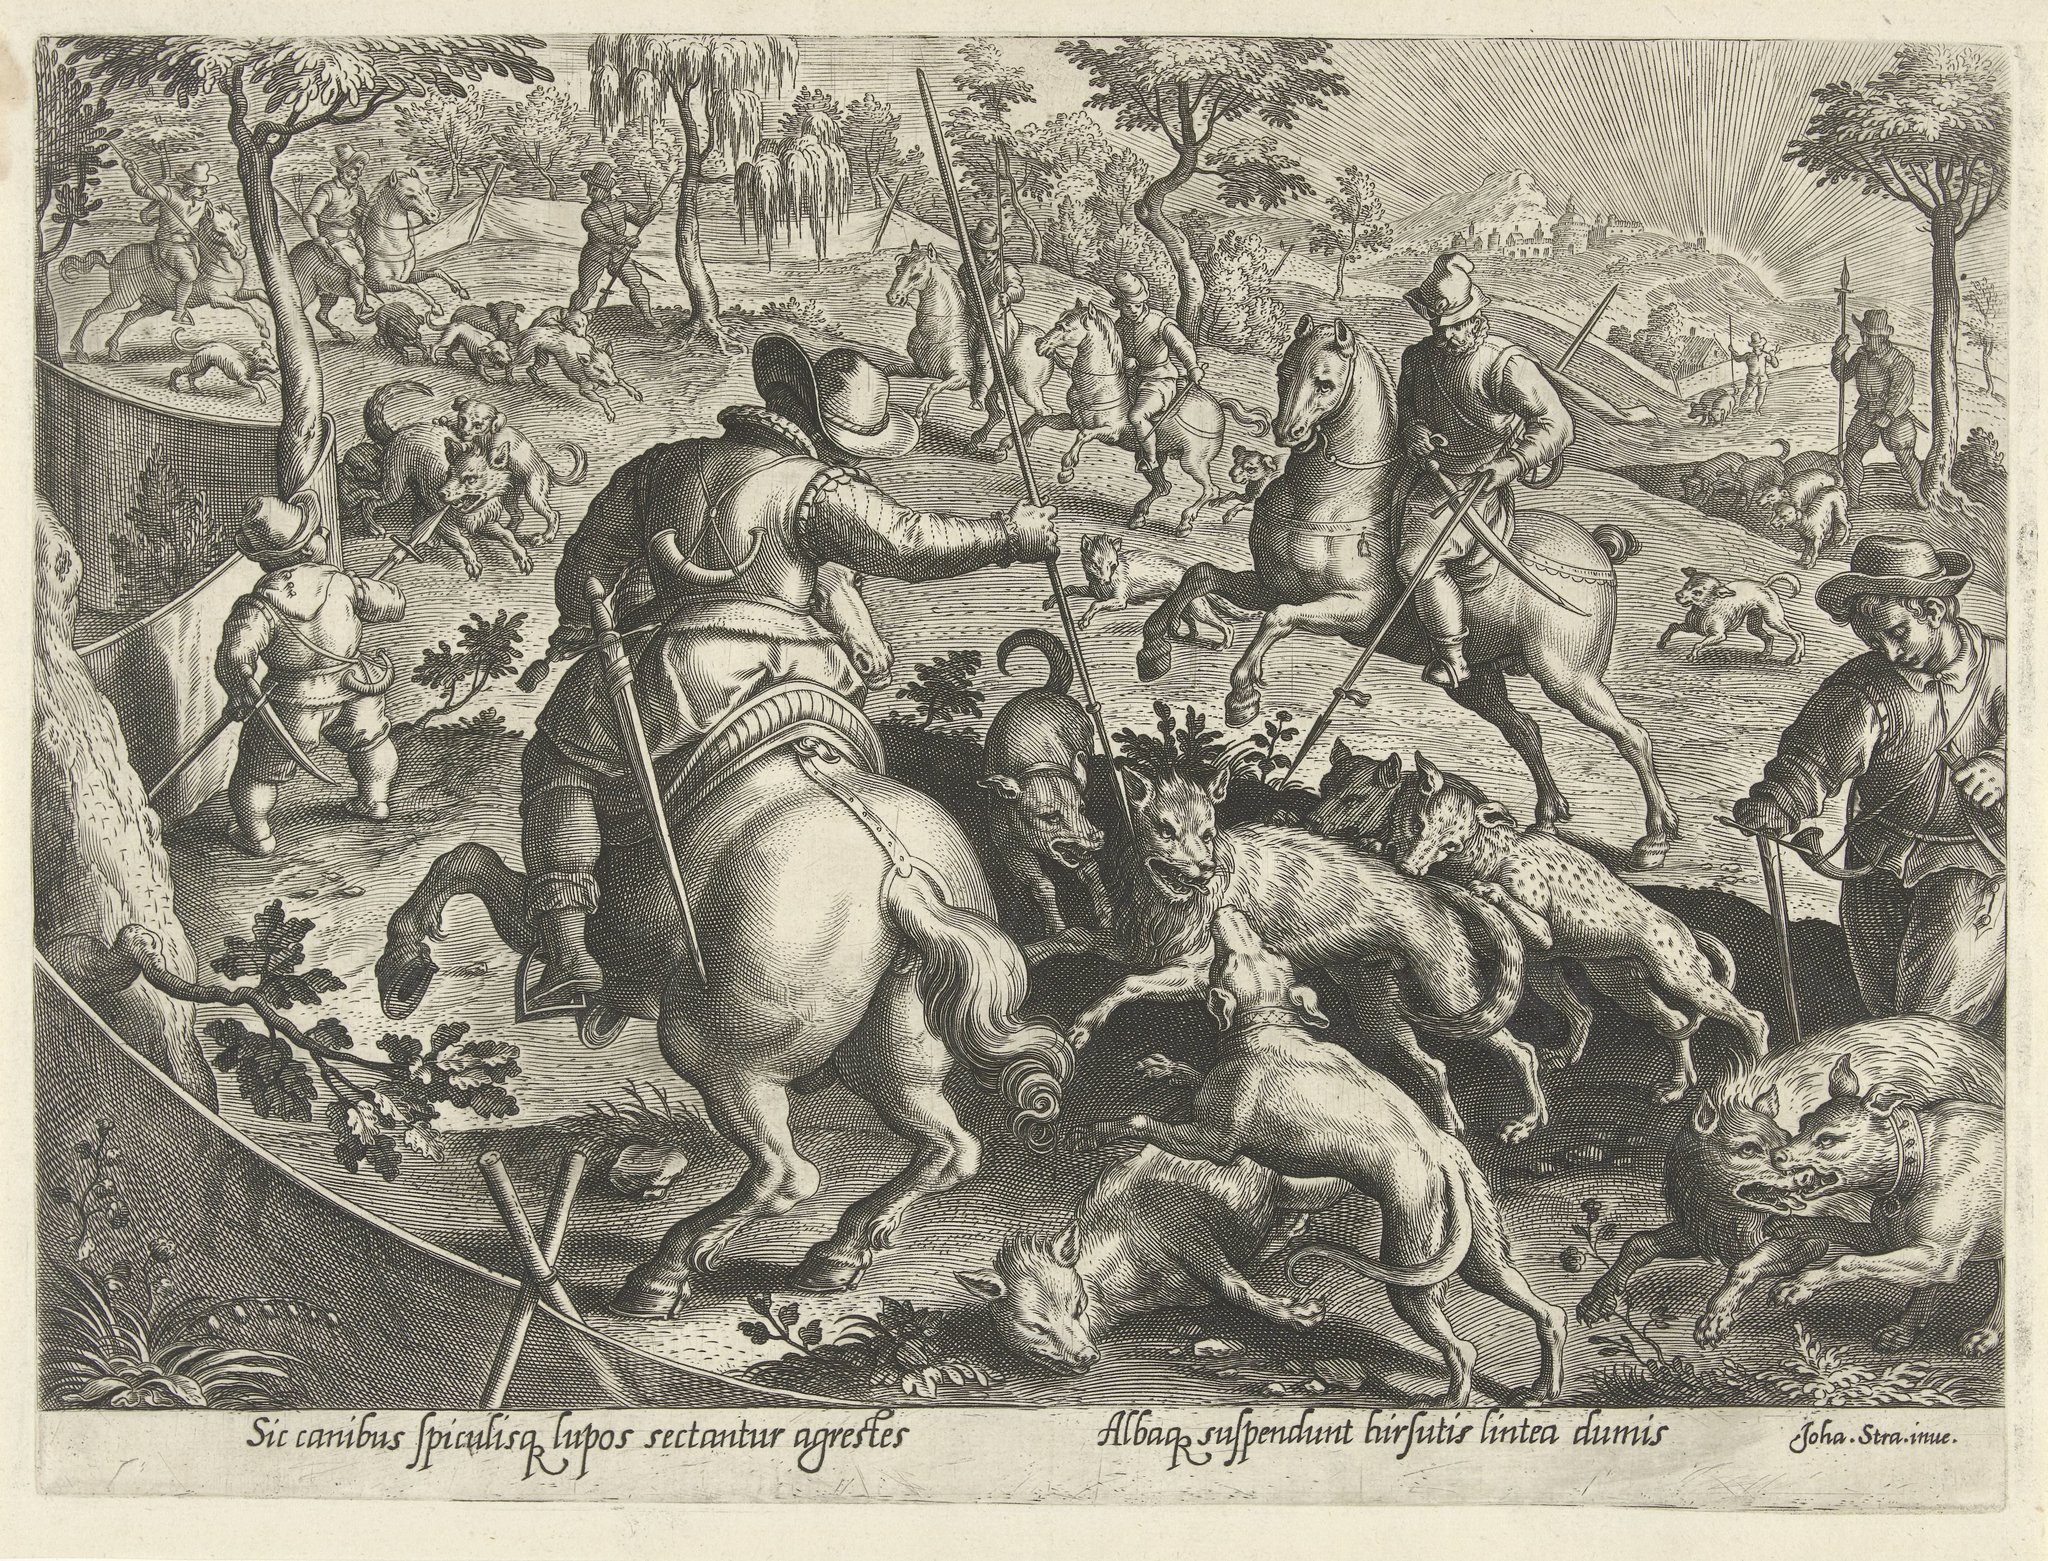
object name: print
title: In quibus omne genus venationis, aucupij, piscatusque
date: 1578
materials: paper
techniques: engraving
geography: antwerp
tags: hunting dogs, hunt ~ predatory animals (fox, lion), beasts of prey, predatory animals: wolf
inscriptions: collector's mark: Lugt 2228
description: Een wolf wordt door honden opgejaagd en vervolgens met speren doorstoken. De prent heeft een Latijns onderschrift en maakt deel uit van een 43-delige serie over de jacht.